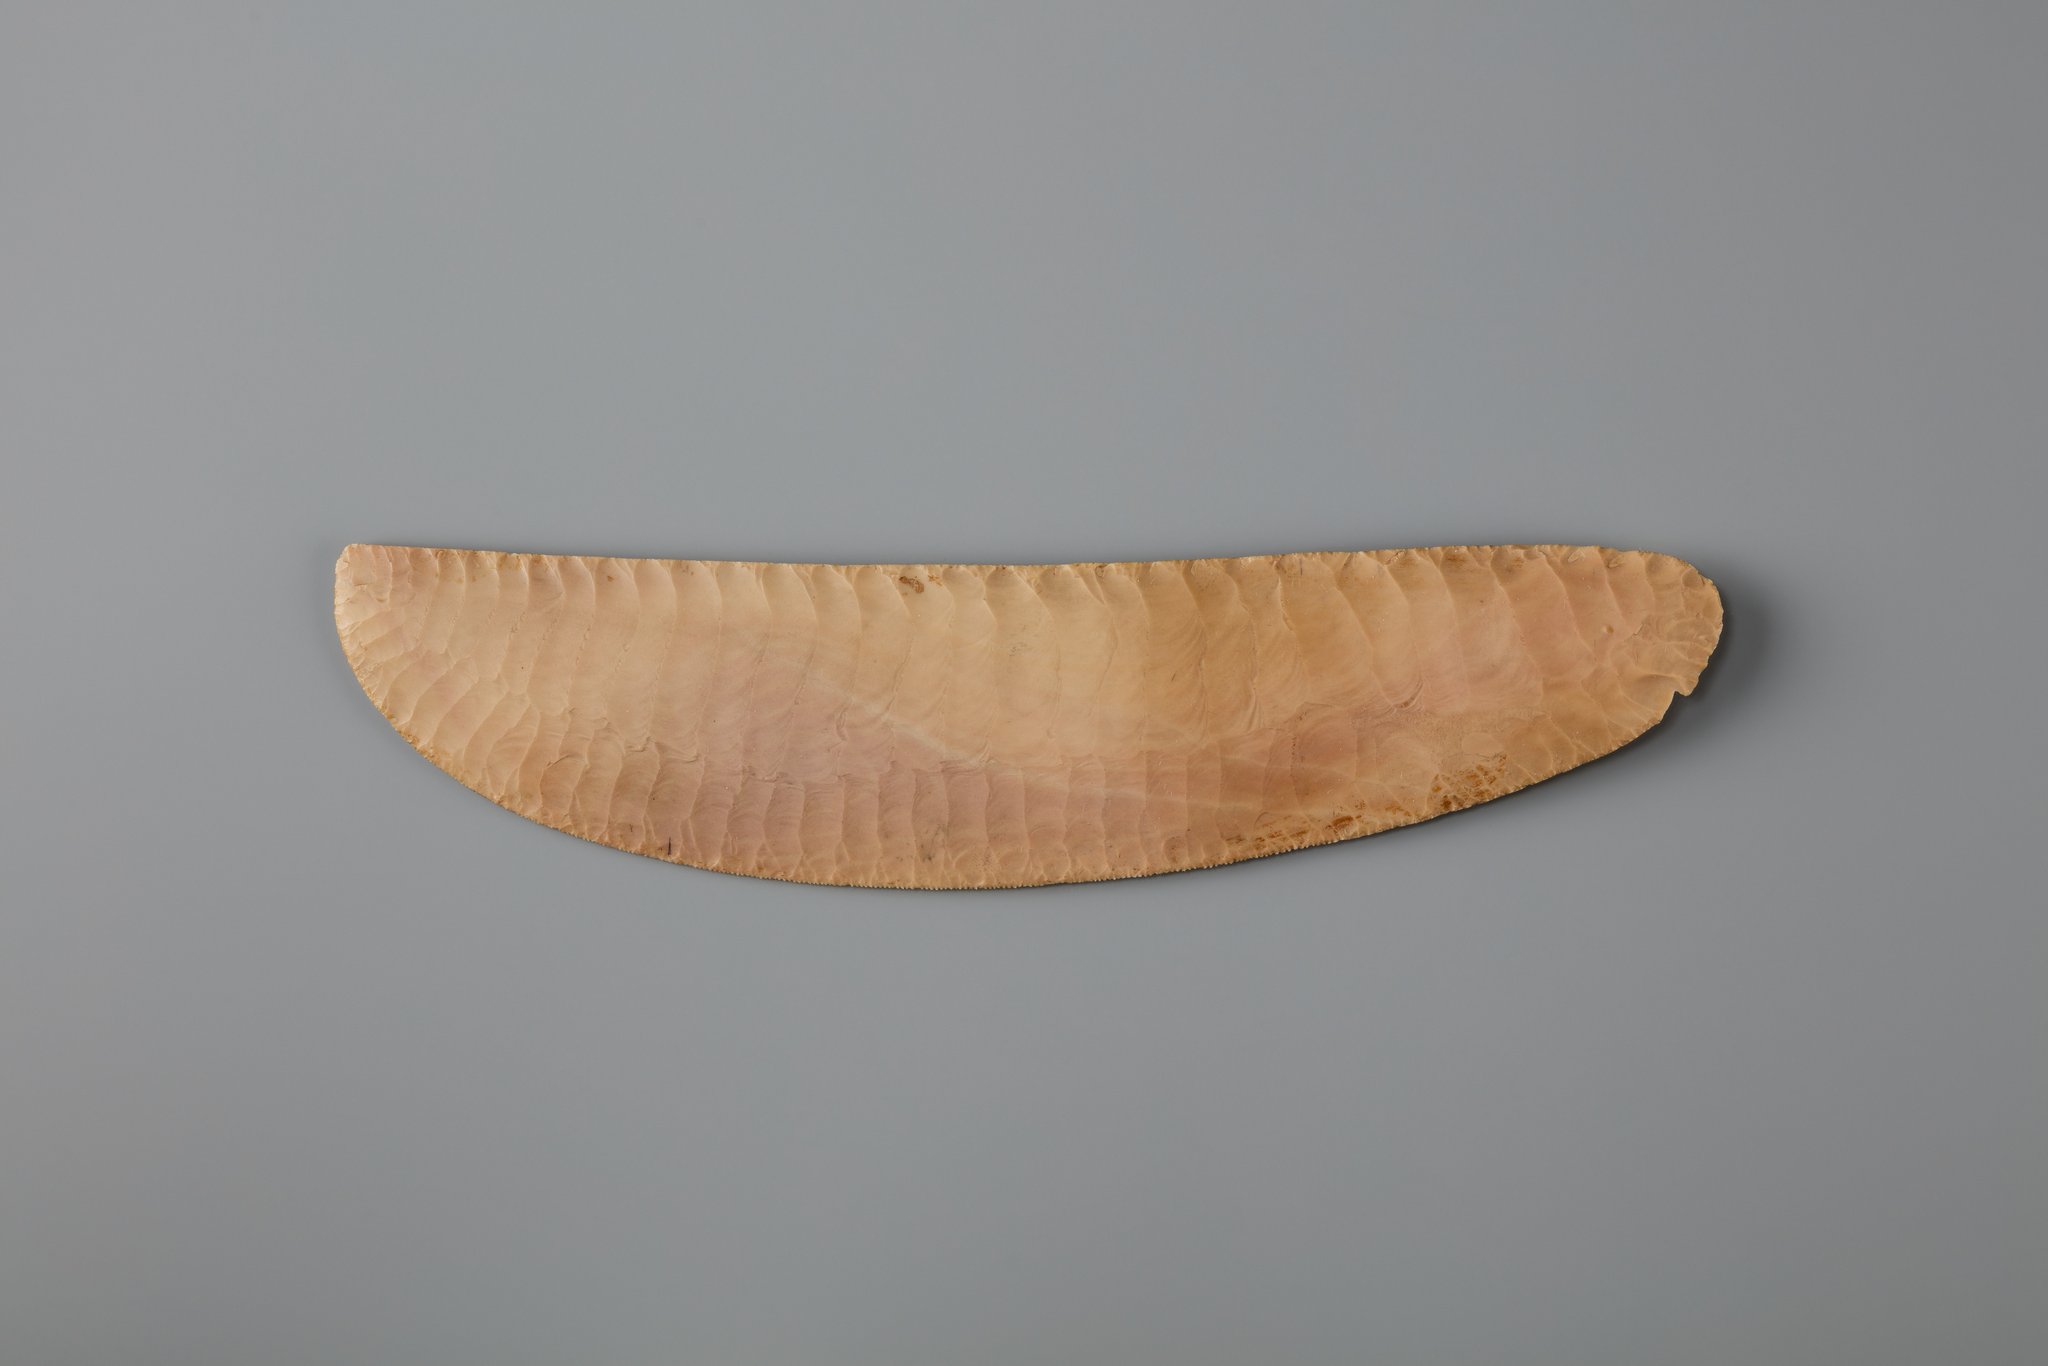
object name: knife, ripple flaked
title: Ripple-Flaked Knife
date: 3650-3100 BCE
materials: stone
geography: egypt